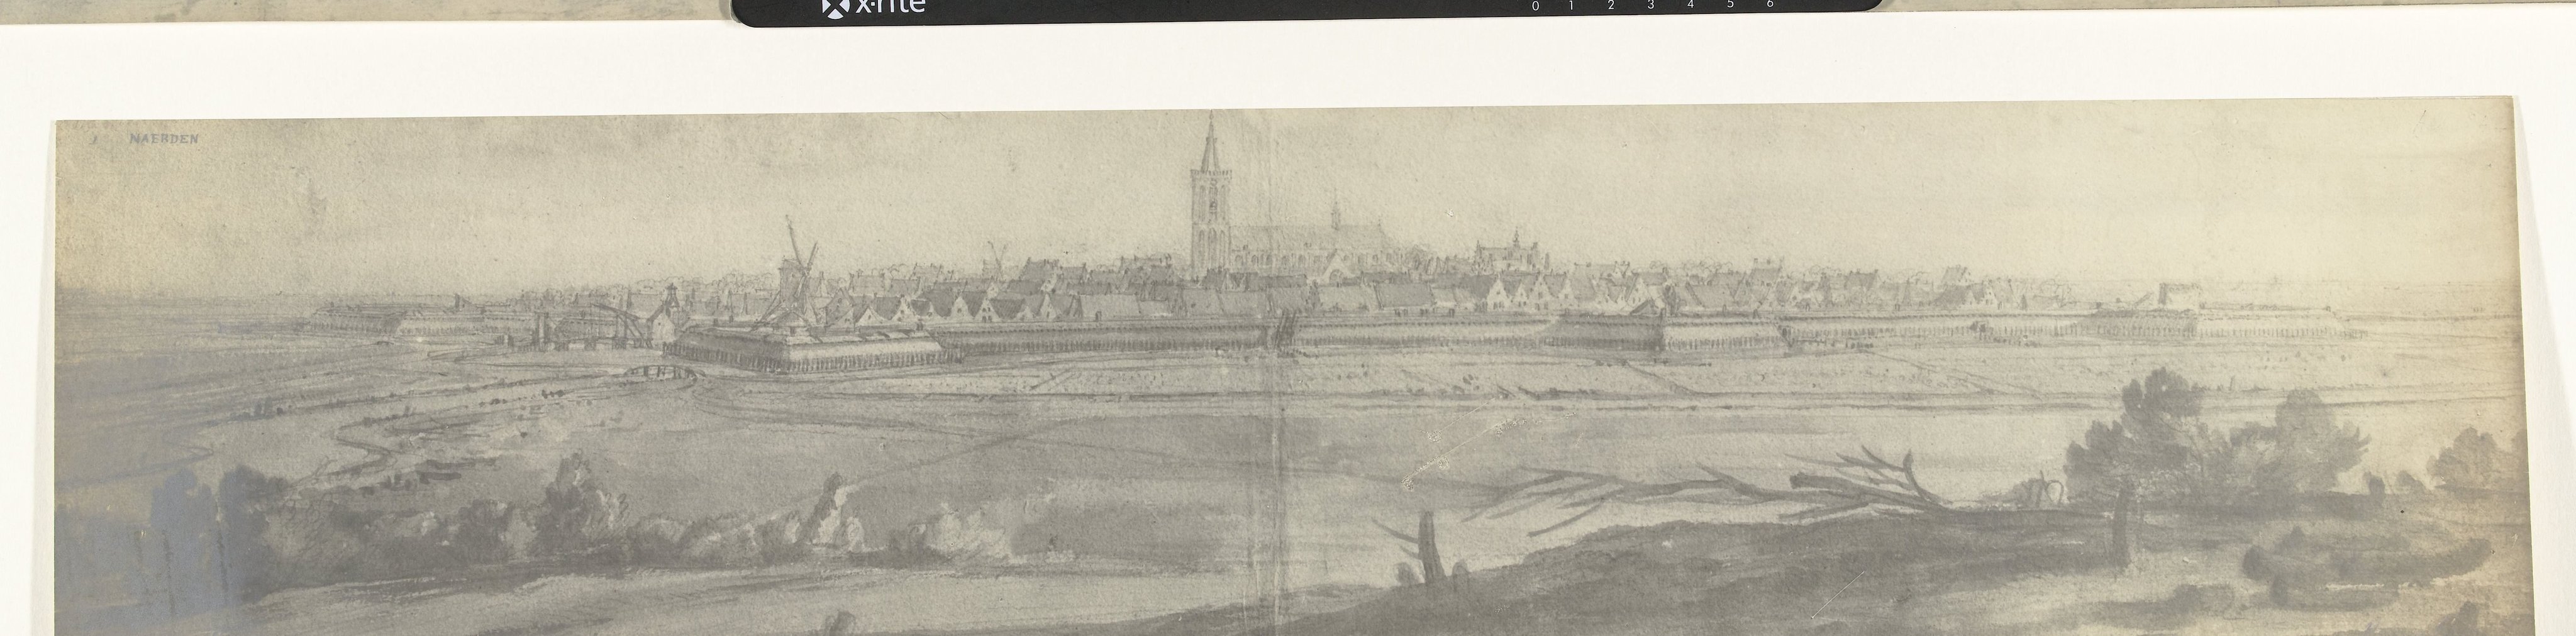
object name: photograph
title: Foto's van tekeningen van de Franse inval in de Nederlanden in 1672 door Adam Frans van der Meulen bewaard in de Manufacture des Gobelins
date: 1900-1903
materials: paper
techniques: gelatin silver print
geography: france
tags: lodewijk xiv (koning van frankrijk), prospect of city, town panorama, silhouette of city, rampjaar (disaster year)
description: Niet in Frederik Muller; door het RPK toegevoegd nummer. Onderdeel van een groep van ca. 50 foto's van tekeningen van de Franse inval in de Nederlanden in 1672 door Adam Frans van der Meulen, bewaard in de Manufacture Nationale des Gobelins te Parijs.